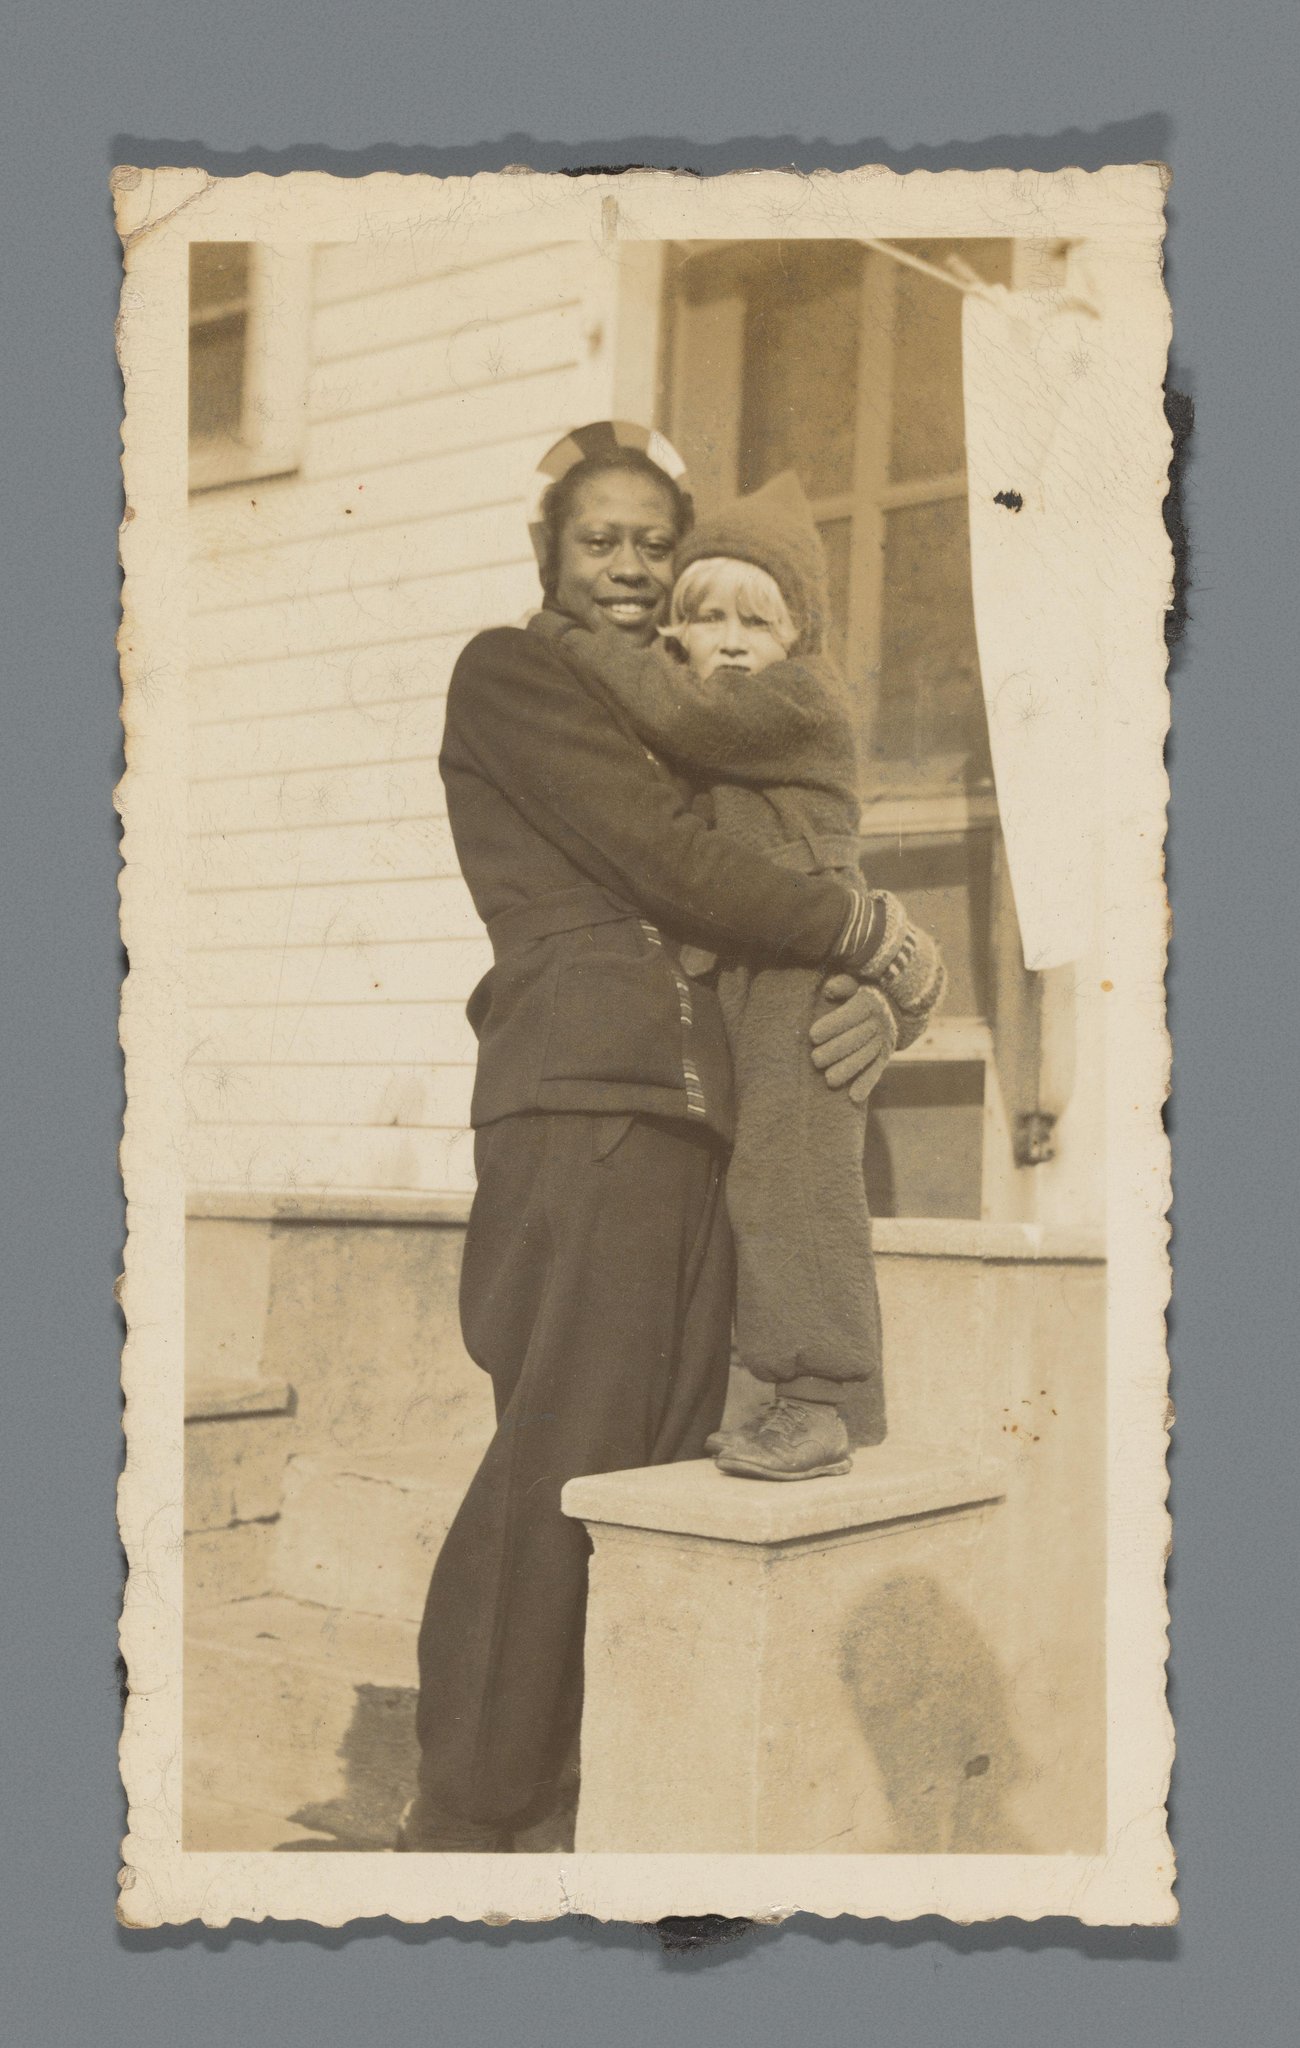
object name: photograph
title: Jonge vrouw en jongen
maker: Anonymous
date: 1935-1950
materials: paper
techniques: gelatin silver print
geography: united states